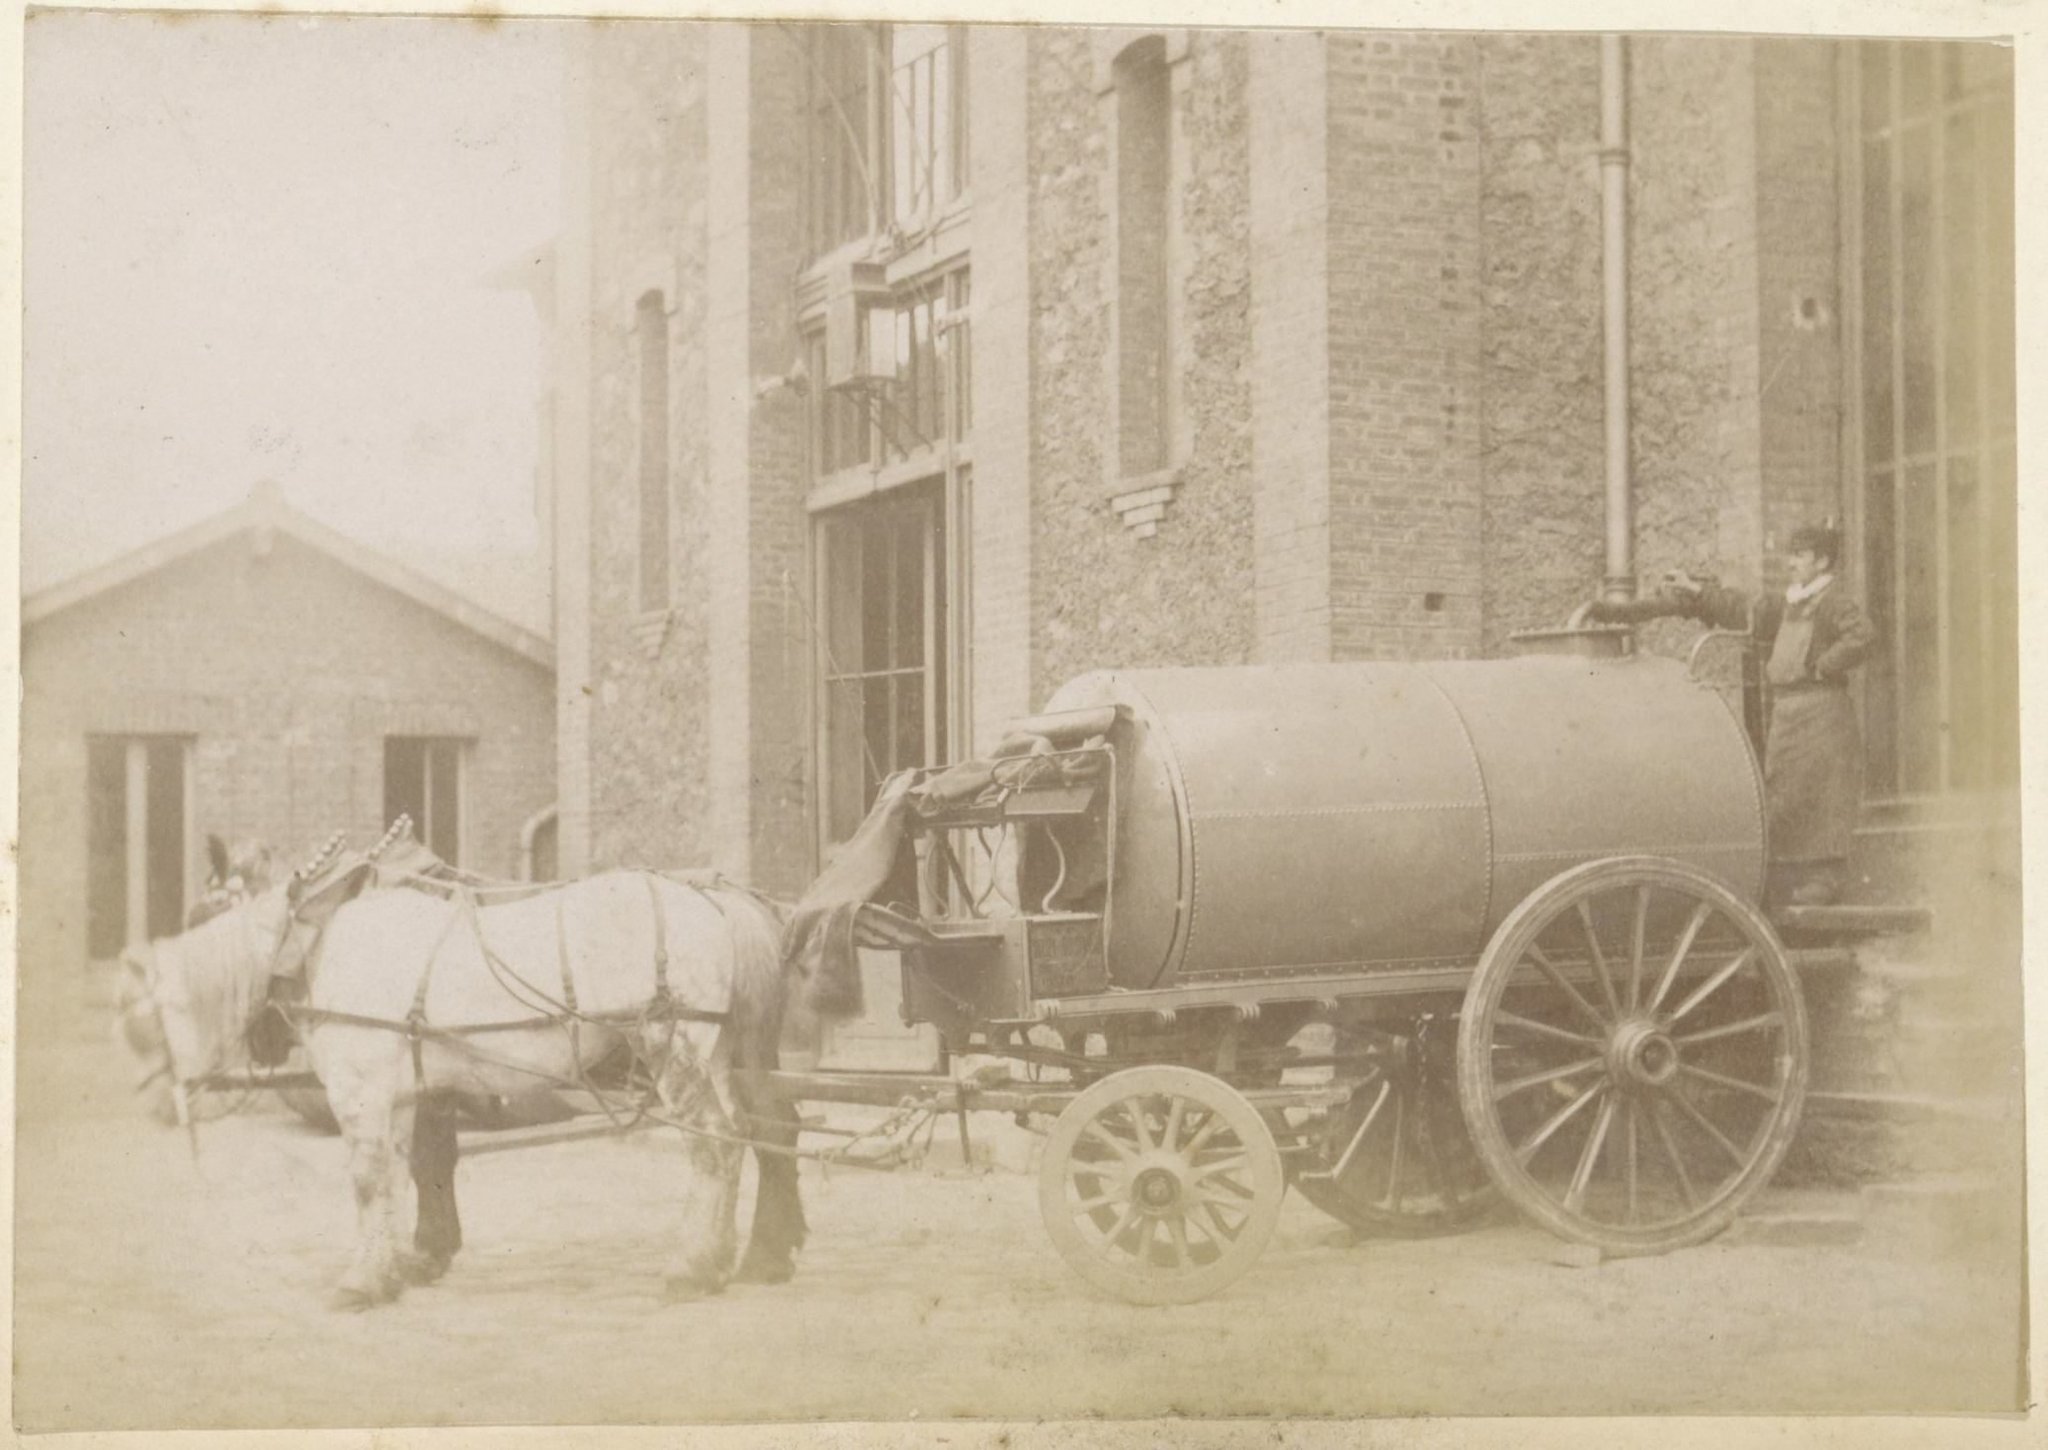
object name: photograph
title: Paard, waterkar en een militair bij een kazerne in Frankrijk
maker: Anonymous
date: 1900-1910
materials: paper, photographic support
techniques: albumen print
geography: france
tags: four-wheeled, animal-drawn vehicle, e.g.: cab, carriage, coach, land forces, container of metal: bucket, can, canister, drum, tin, france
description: Onderdeel van Fotoalbum van een Franse amateurfotograaf met opnames van een familie, distilleerderij Delizy & Doistau Fils, het leger en bezienswaardigheden in Frankrijk.